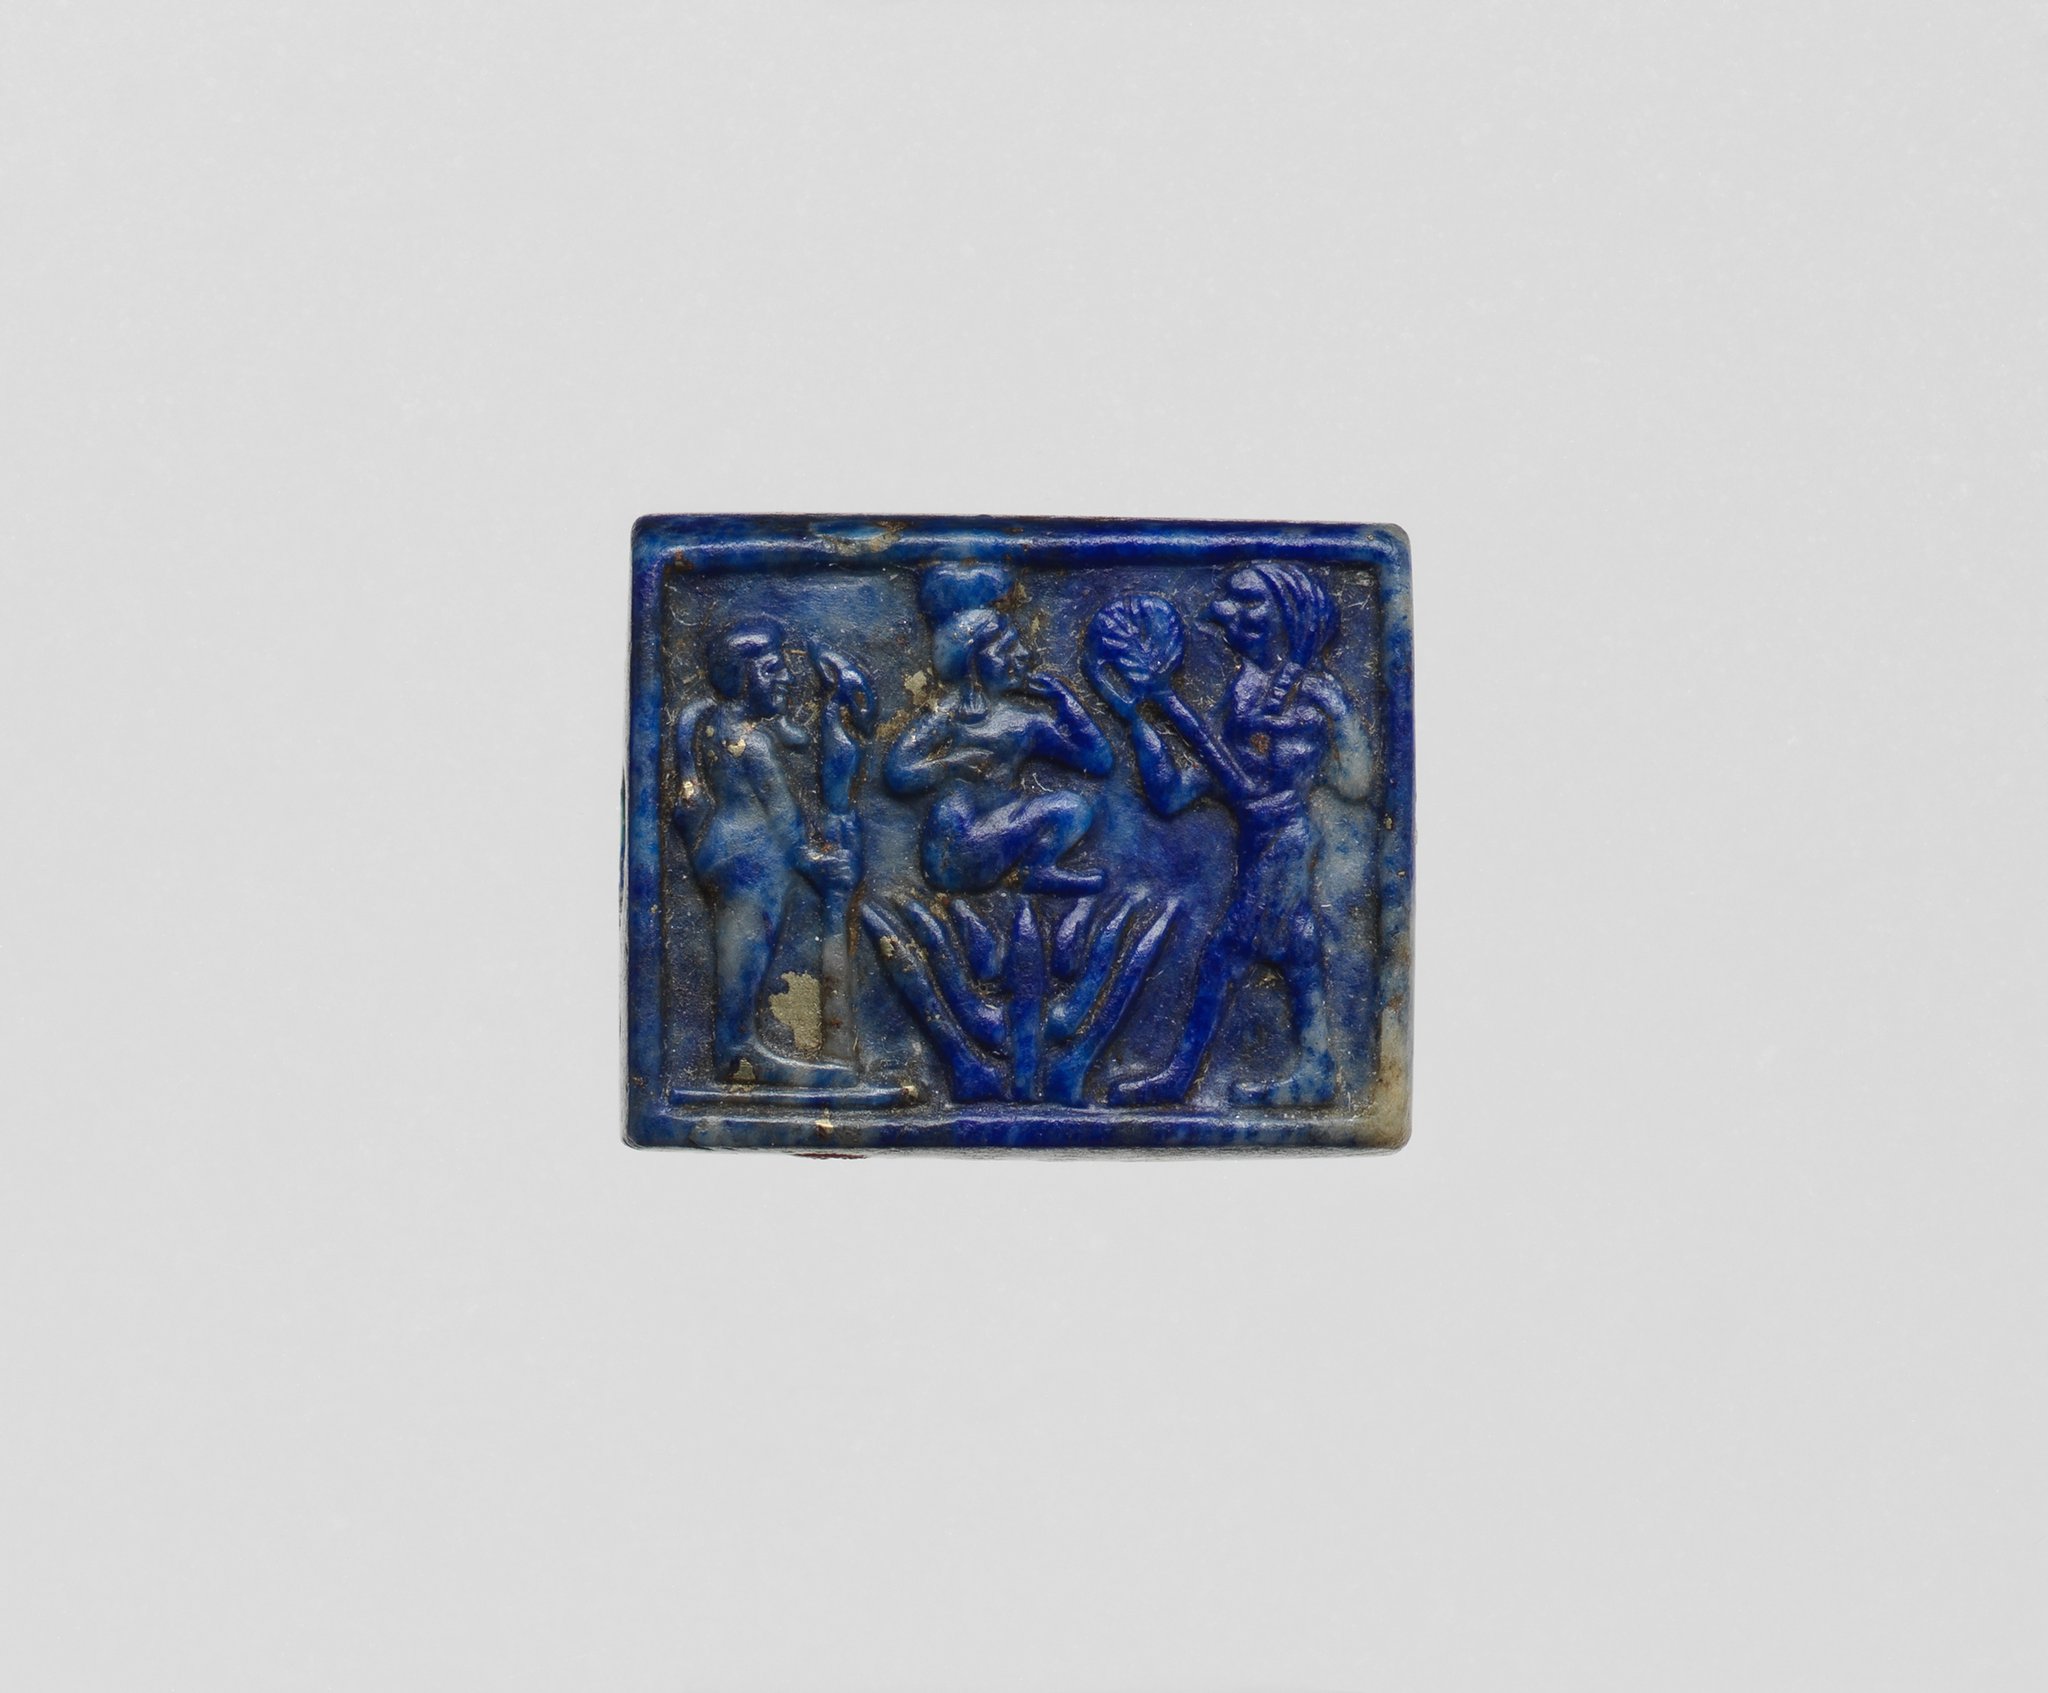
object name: amulet plaque, harpokrates, re harakhty, ptah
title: Plaque with Harpokrates (or similar) on a lotus, Ptah and Re-Harakhty(?)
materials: lapis lazuli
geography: egypt